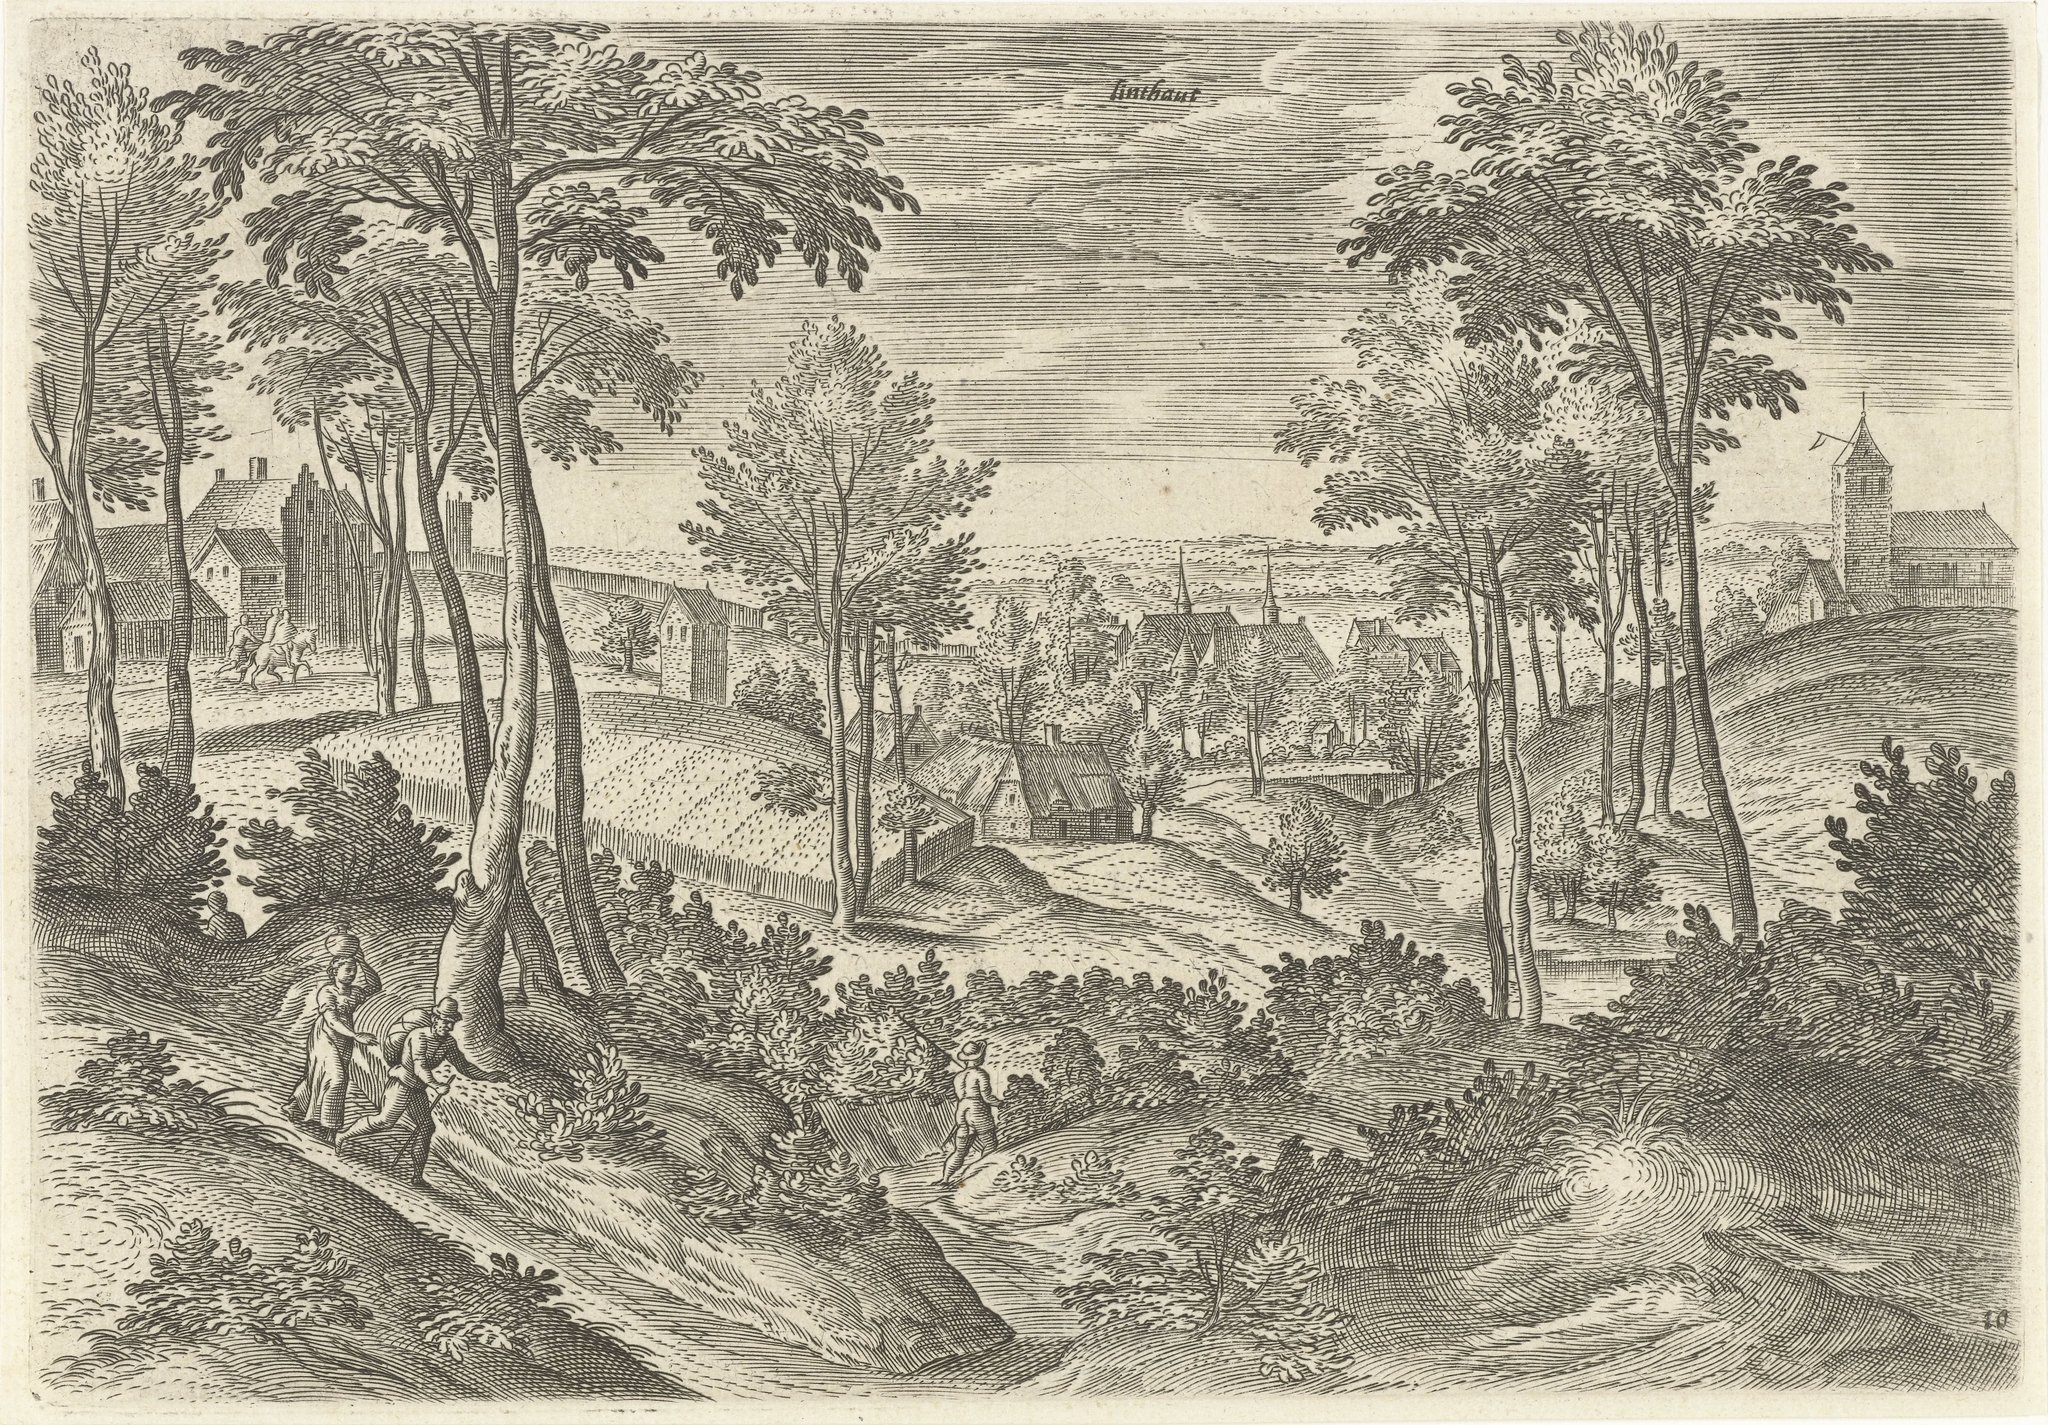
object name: print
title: Gezicht op Linthout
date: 1530-1580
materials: paper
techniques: engraving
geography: antwerp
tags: village (+ city(-scape) with figures, staffage), brussels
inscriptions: collector's mark: Lugt 2228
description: Gezicht op het dorp Linthout, vlakbij Brussel. De prent is deel van een serie met gezichten uit de omgeving van Brussel.